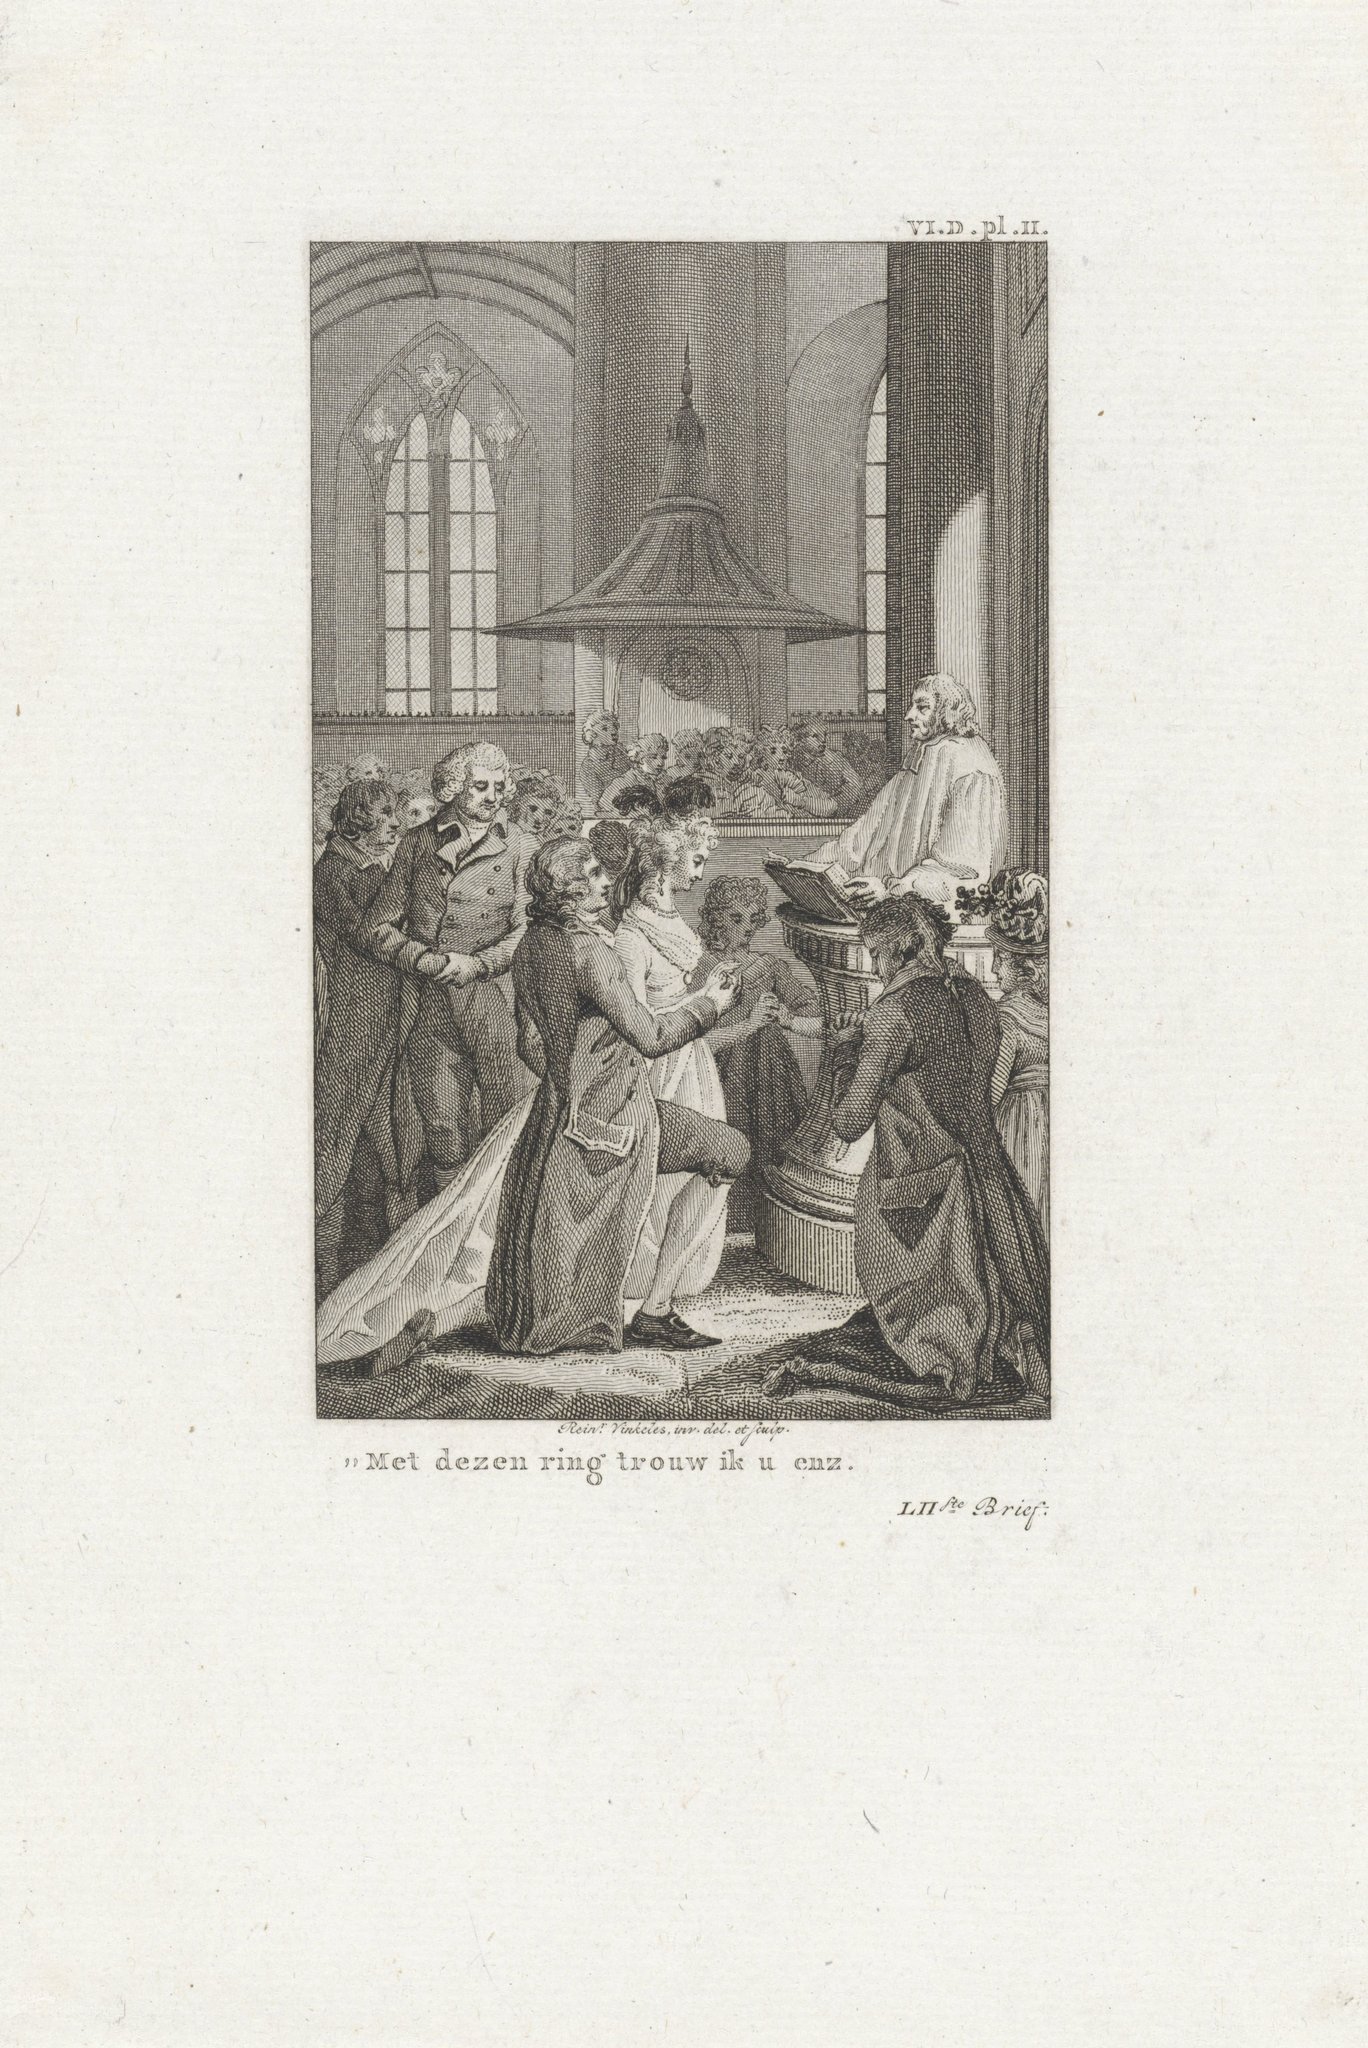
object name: print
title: Kerkelijke huwelijksceremonie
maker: reinier vinkeles (i)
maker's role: draughtsman, print maker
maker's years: 1741-1816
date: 1797-1802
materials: paper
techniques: engraving, etching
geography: amsterdam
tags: wedding ring, interior of church, (civil) marriage ceremonies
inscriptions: collector's mark: Lugt 240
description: Illustratie uit: Richardson, Samuel. Geschiedenis van Karel Grandison. Amsterdam: Johannes Allart, 1797-1802.